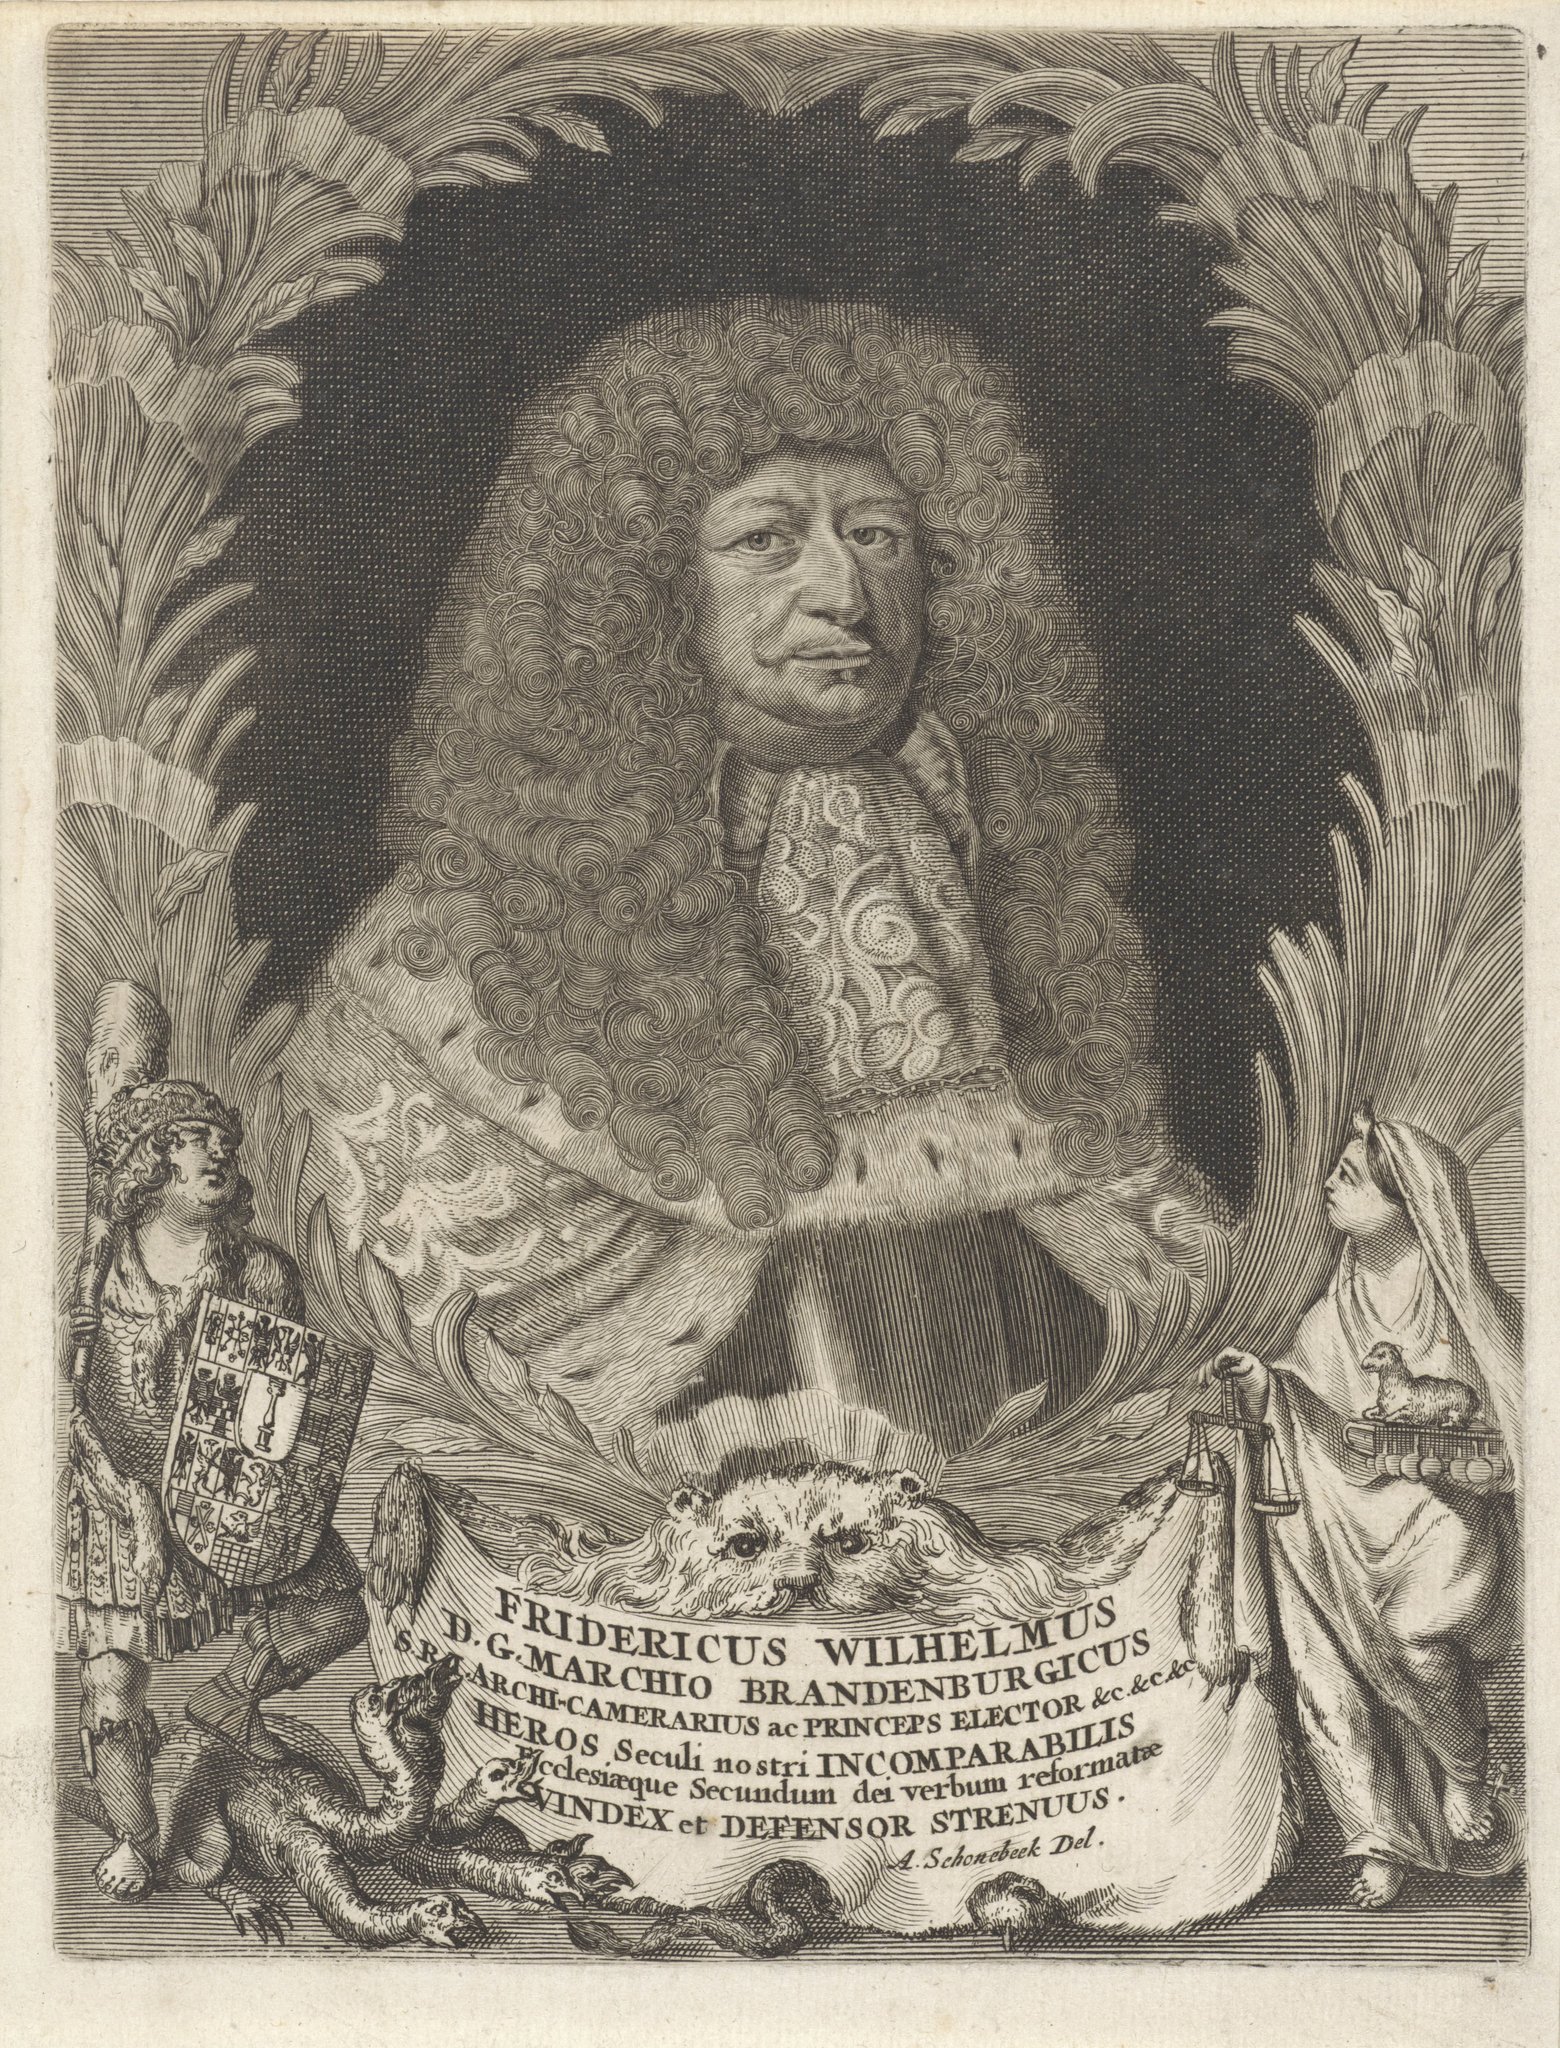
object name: print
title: Portret van Frederik Willem, keurvorst van Brandenburg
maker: adriaen schoonebeek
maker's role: print maker, publisher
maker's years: 1661-1705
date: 1688-1705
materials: paper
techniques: engraving, etching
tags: berlin, frederik willem van brandenburg (i), specific aspects, allegorical aspects of hercules; hercules as patron - triumph, justice, 'justitia'; 'giustitia divina' (ripa) ~ one of the four cardinal virtues - mm - triumph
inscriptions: collector's mark: Lugt 2228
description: Portret van Frederik Willem, keurvorst van Brandenburg, omgeven door een guirlande. Linksonder Hercules en rechtsonder een vrouwenfiguur, mogelijk Rechtvaardigheid. De vrouw draagt een lam en een boek met zegels op haar arm. Hercules houdt met zijn voet de hydra van Lerna in bedwang en draagt het wapenschild van de keurvorst. Op een draperie met Hercules' leeuwenvel de naam en titels van de geportretteerde in het Latijn.